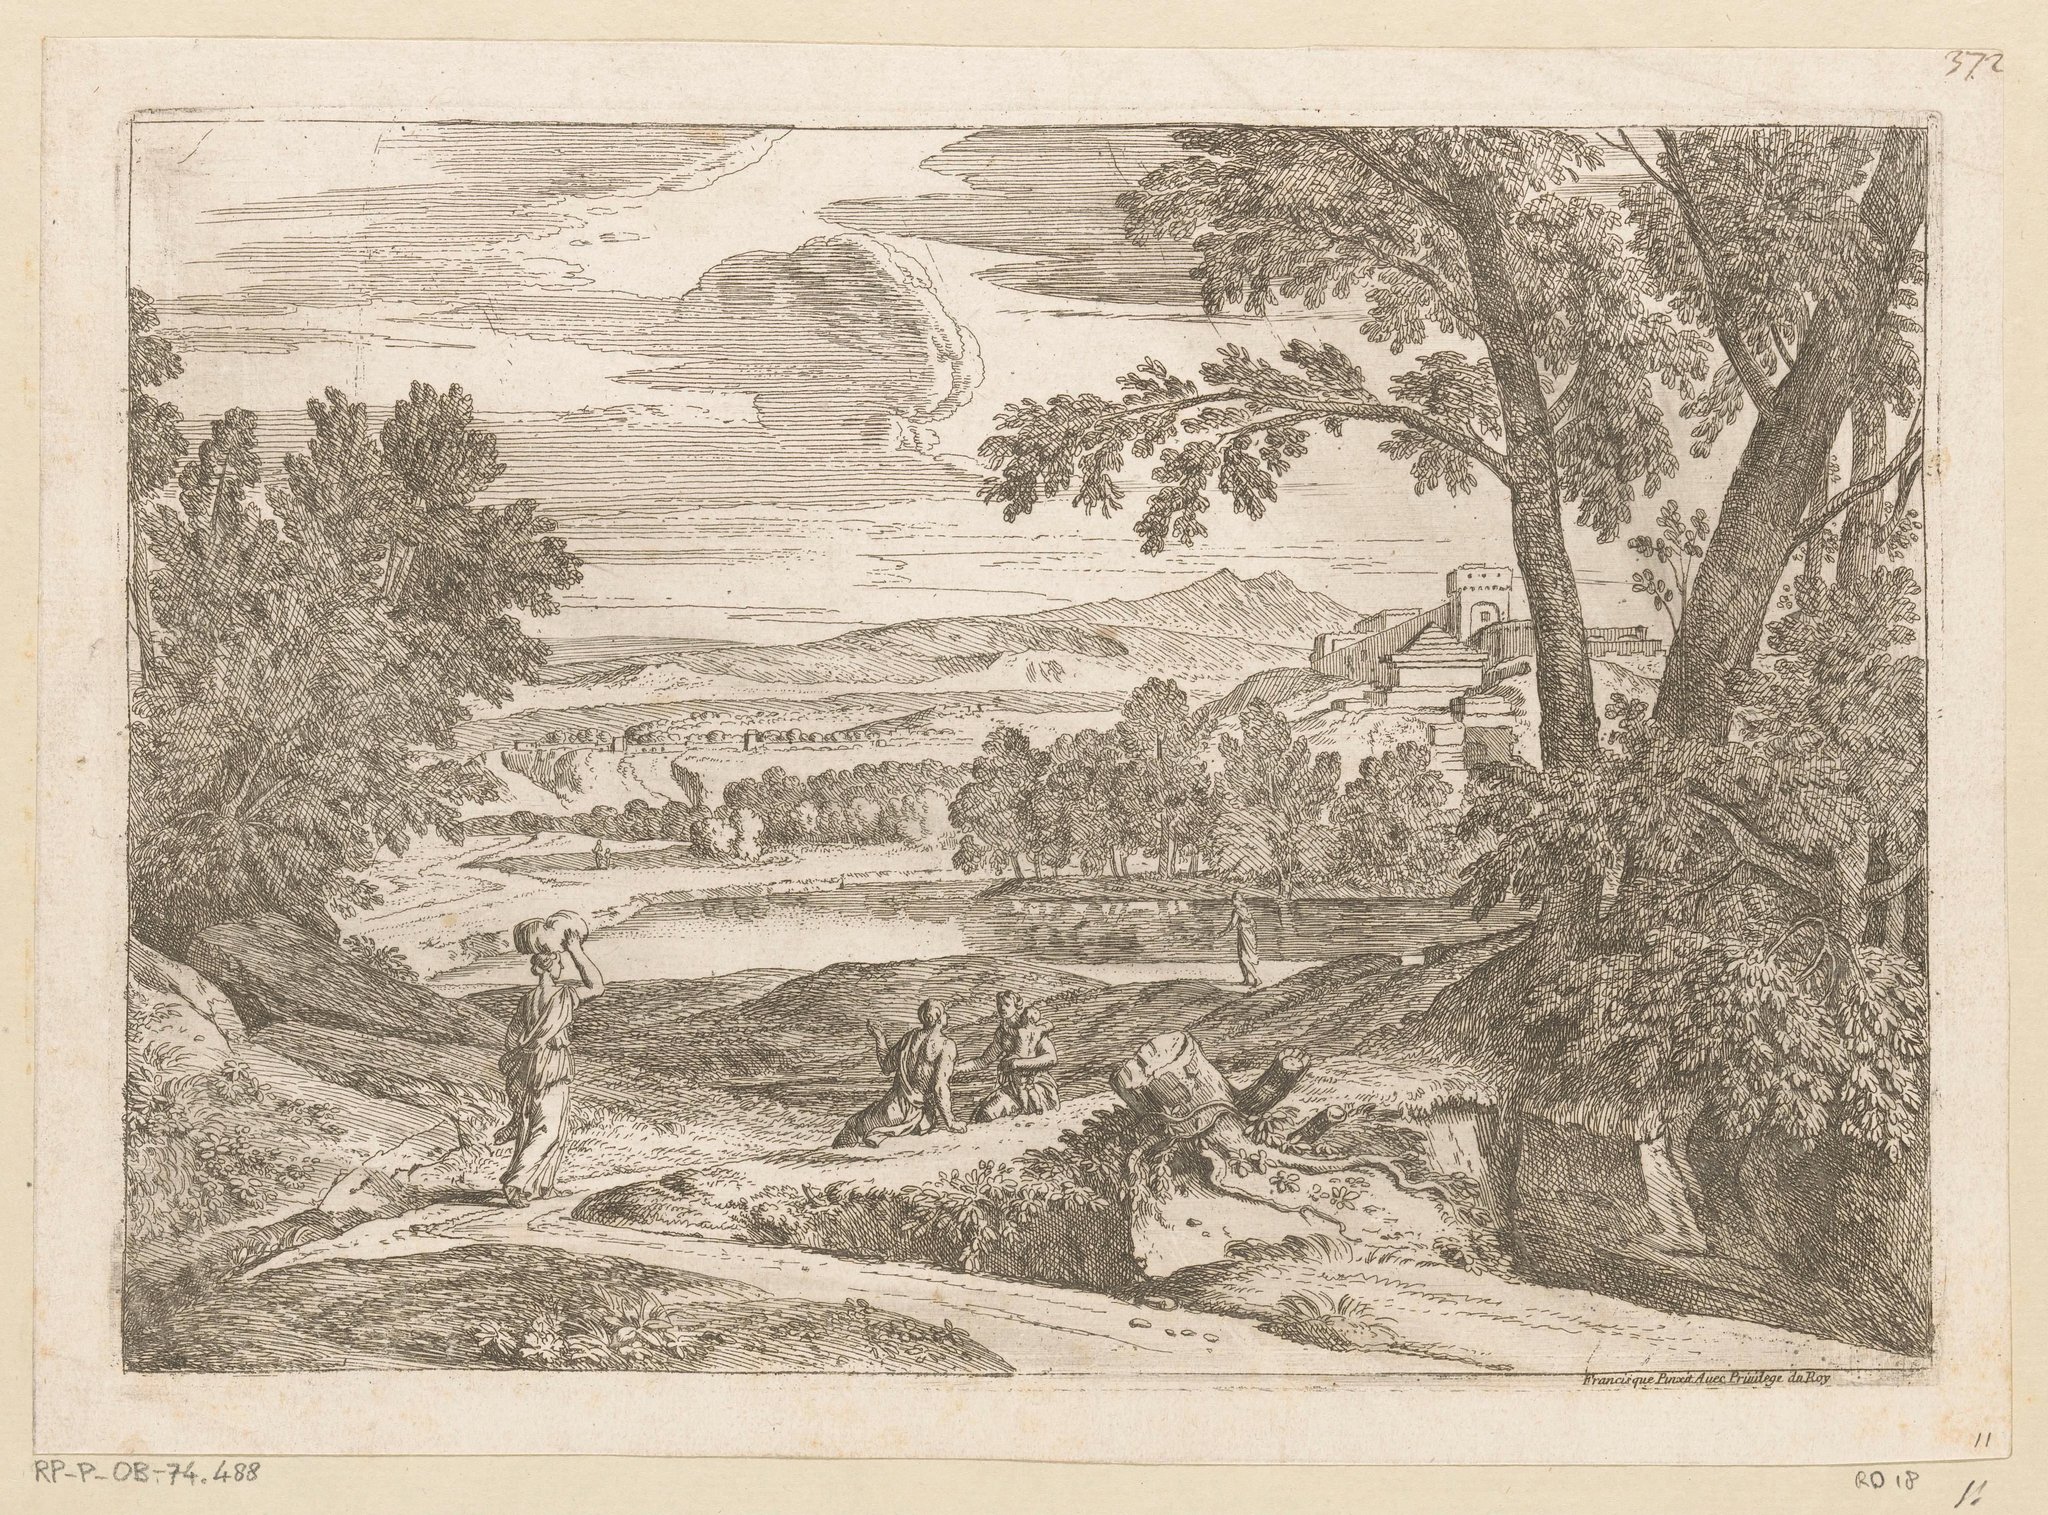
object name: print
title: Arcadisch landschap met een lopende vrouw en een gezin zittend langs een pad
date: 1690-1730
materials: paper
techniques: etching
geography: france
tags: landscapes in the temperate zone - hh - ideal landscapes, road, path, family life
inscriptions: collector's mark: Lugt 240